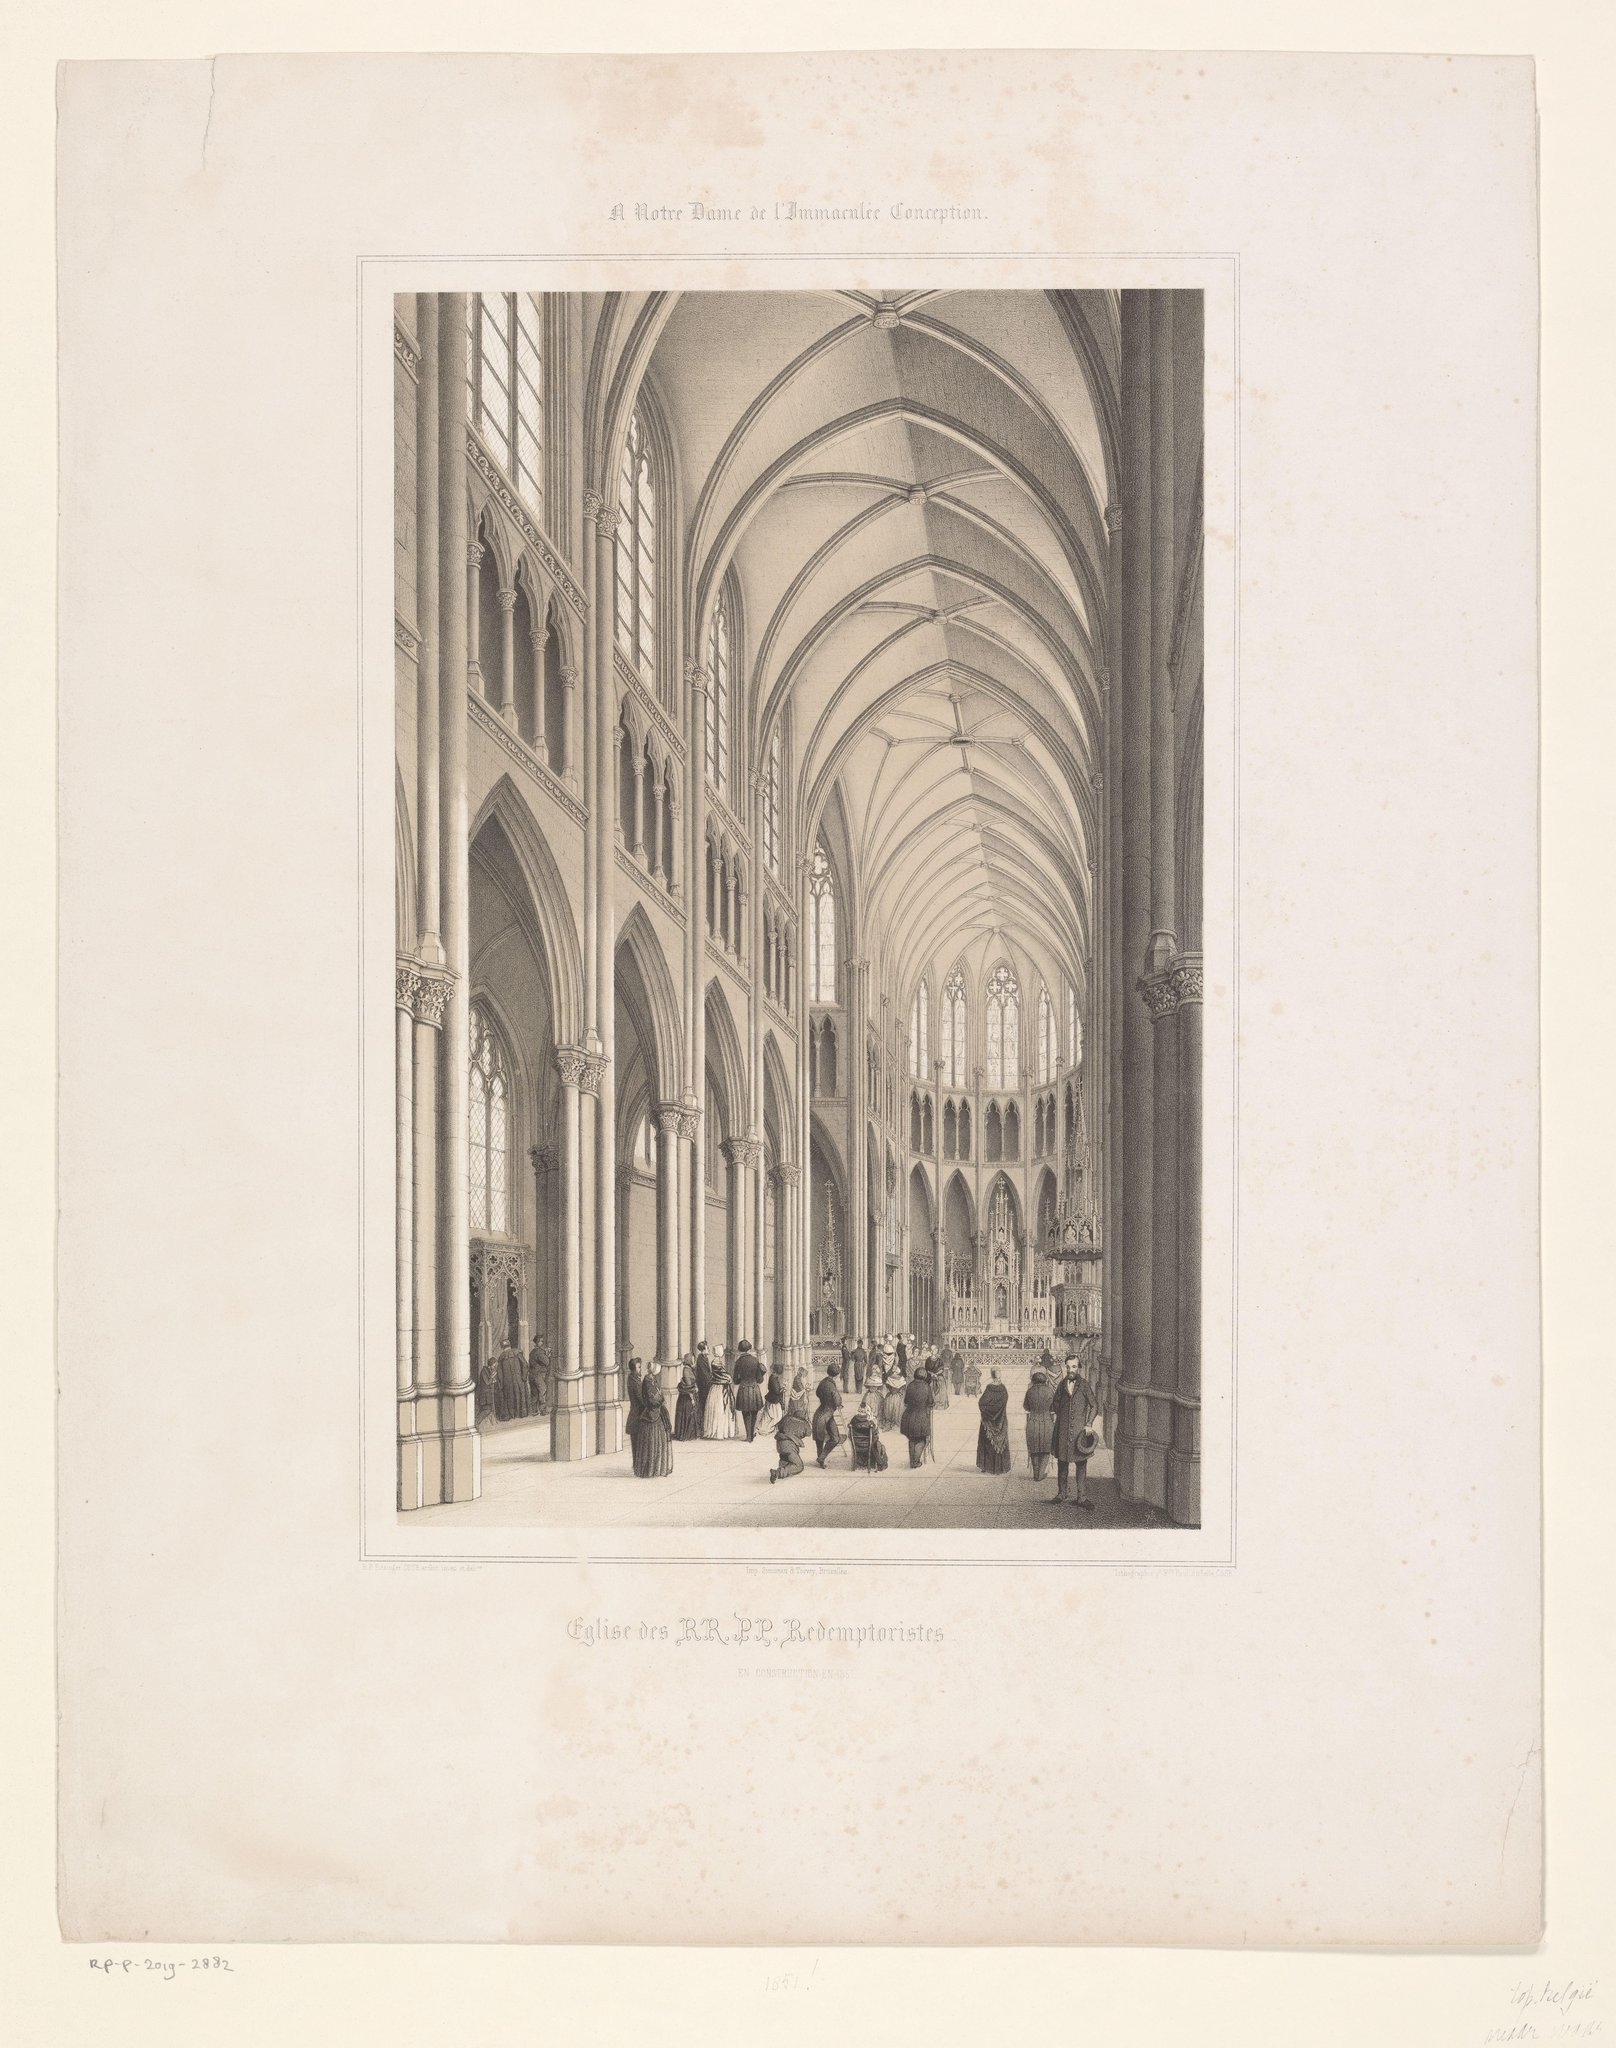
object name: print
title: A Notre Dame de l'Immaculée Conception. Eglise des RR. PP. Redemptoristes en construction en 1851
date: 1851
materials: paper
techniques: tone lithography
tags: interior of church, belgium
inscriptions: collector's mark: Lugt 2228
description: Interieur van de Onze-Lieve-Vrouw-Onbevlekt-Ontvangenkerk, de kerk van de Redemptoristen.